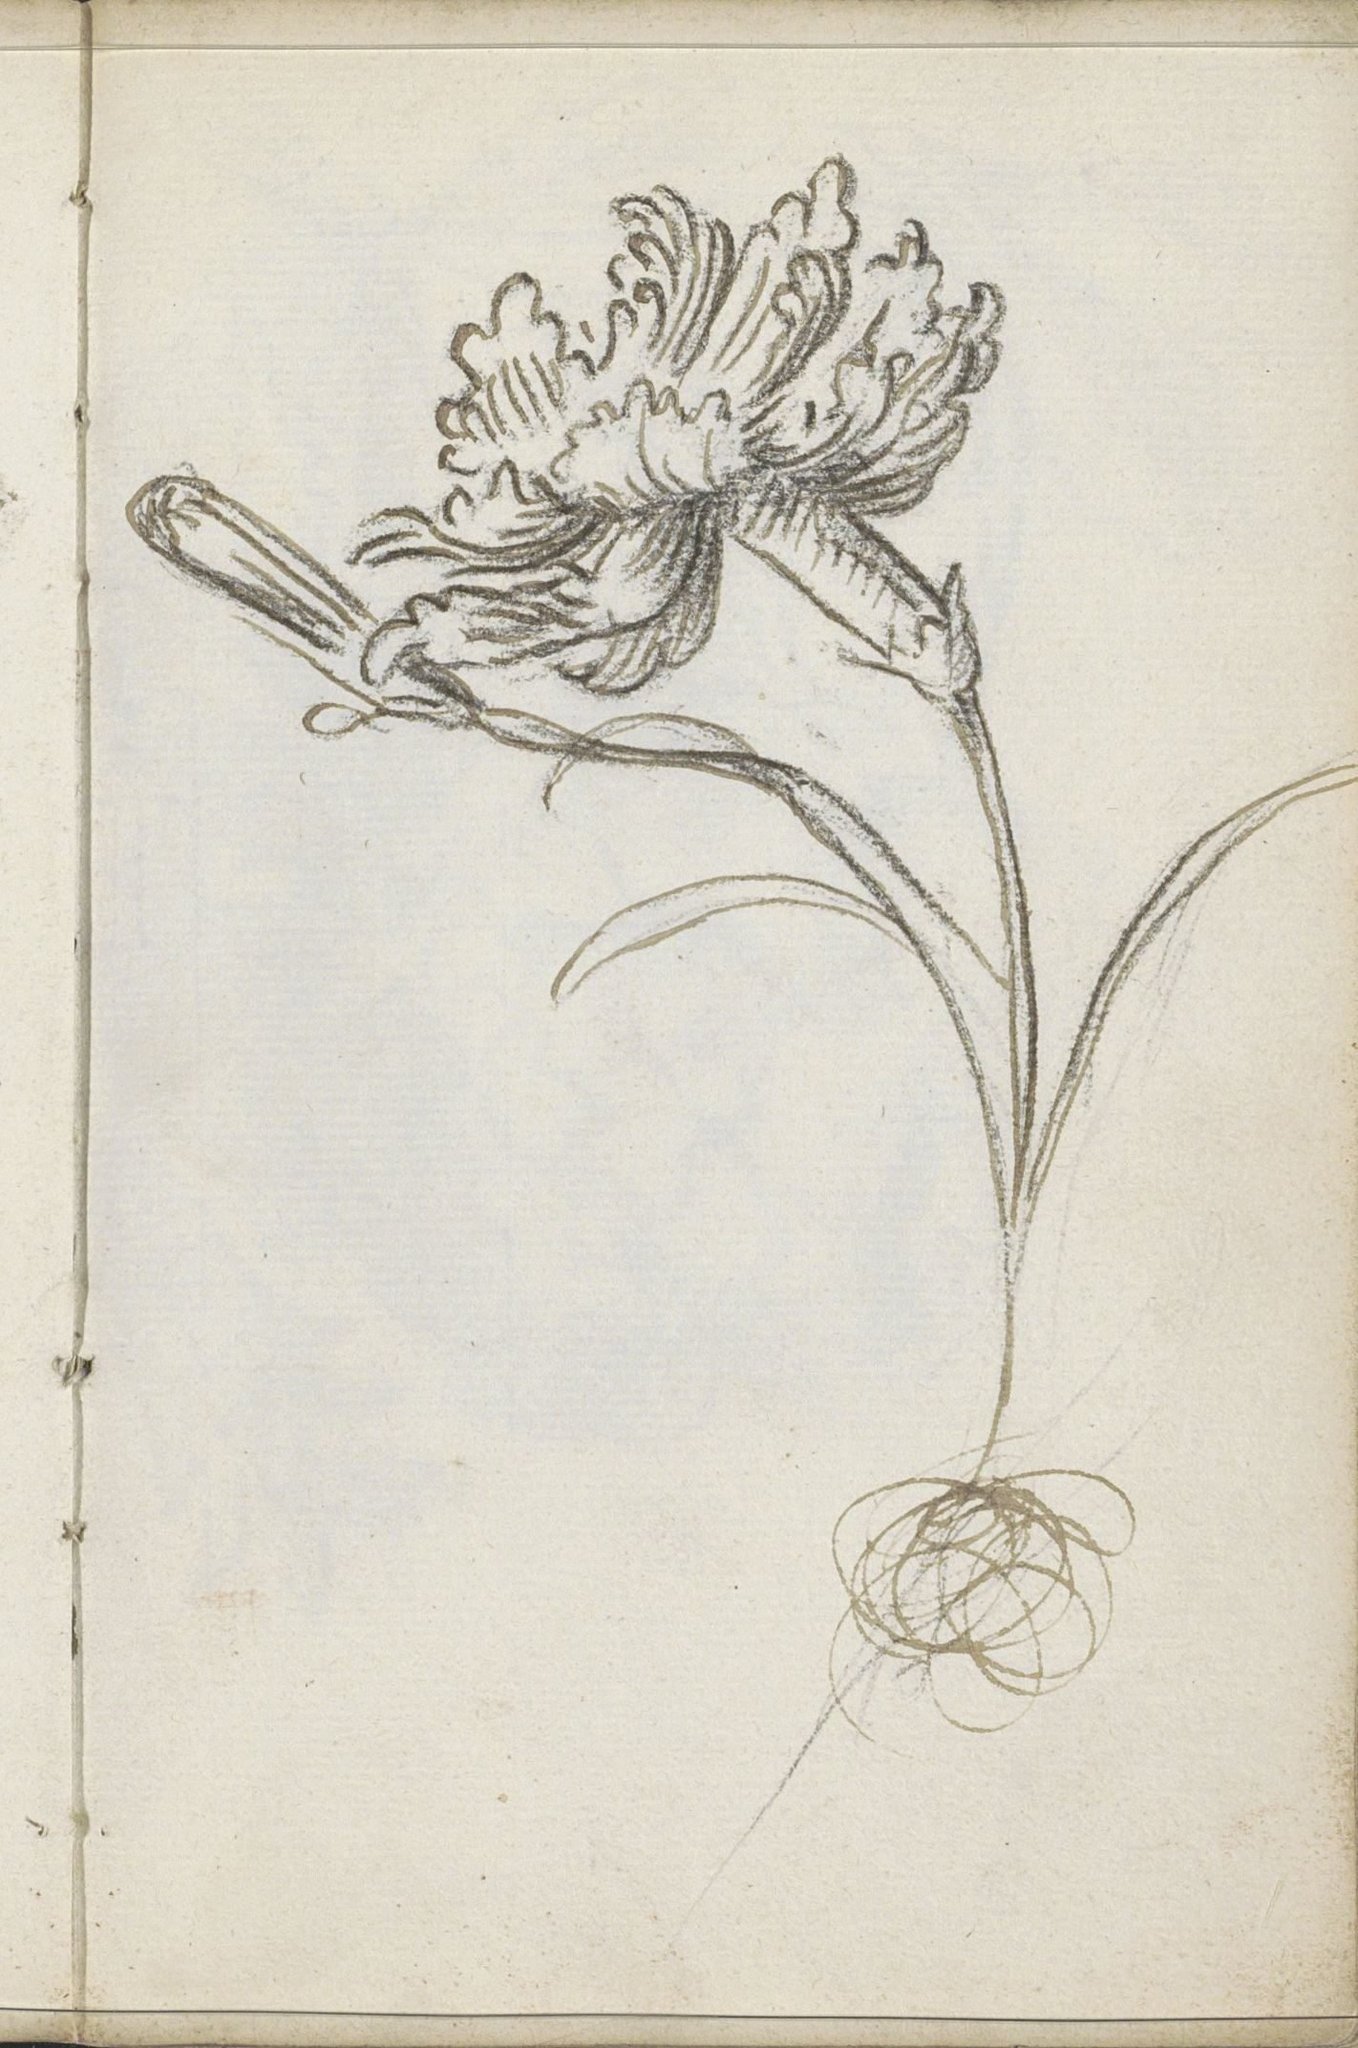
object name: sketchbook leaf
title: Bloemen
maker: petrus johannes van reysschoot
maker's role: draughtsman, print maker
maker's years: 1702-1772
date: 1710-1772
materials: chalk, ink, paper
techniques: pen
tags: flowers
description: Recto van een ongenummerd blad tussen blad 10 en 11 uit een schetsboek met 105 bladen.